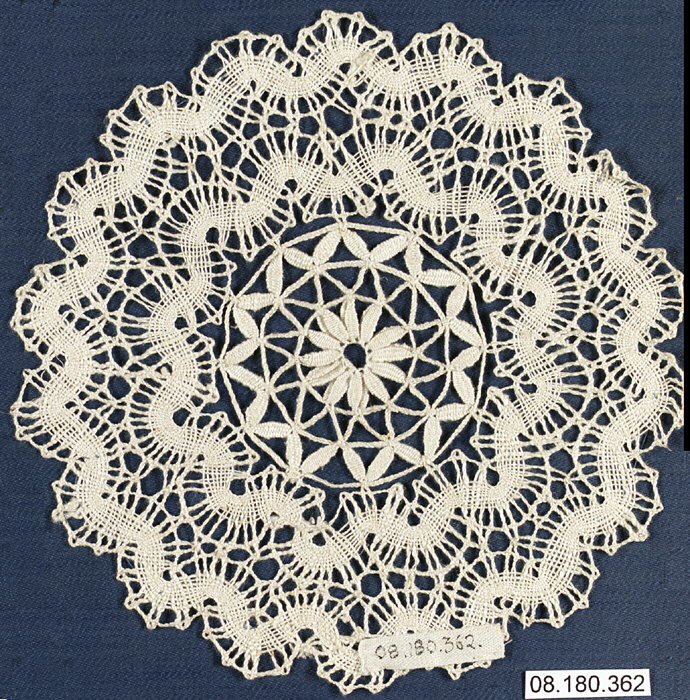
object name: mat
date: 1801-1900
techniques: lace